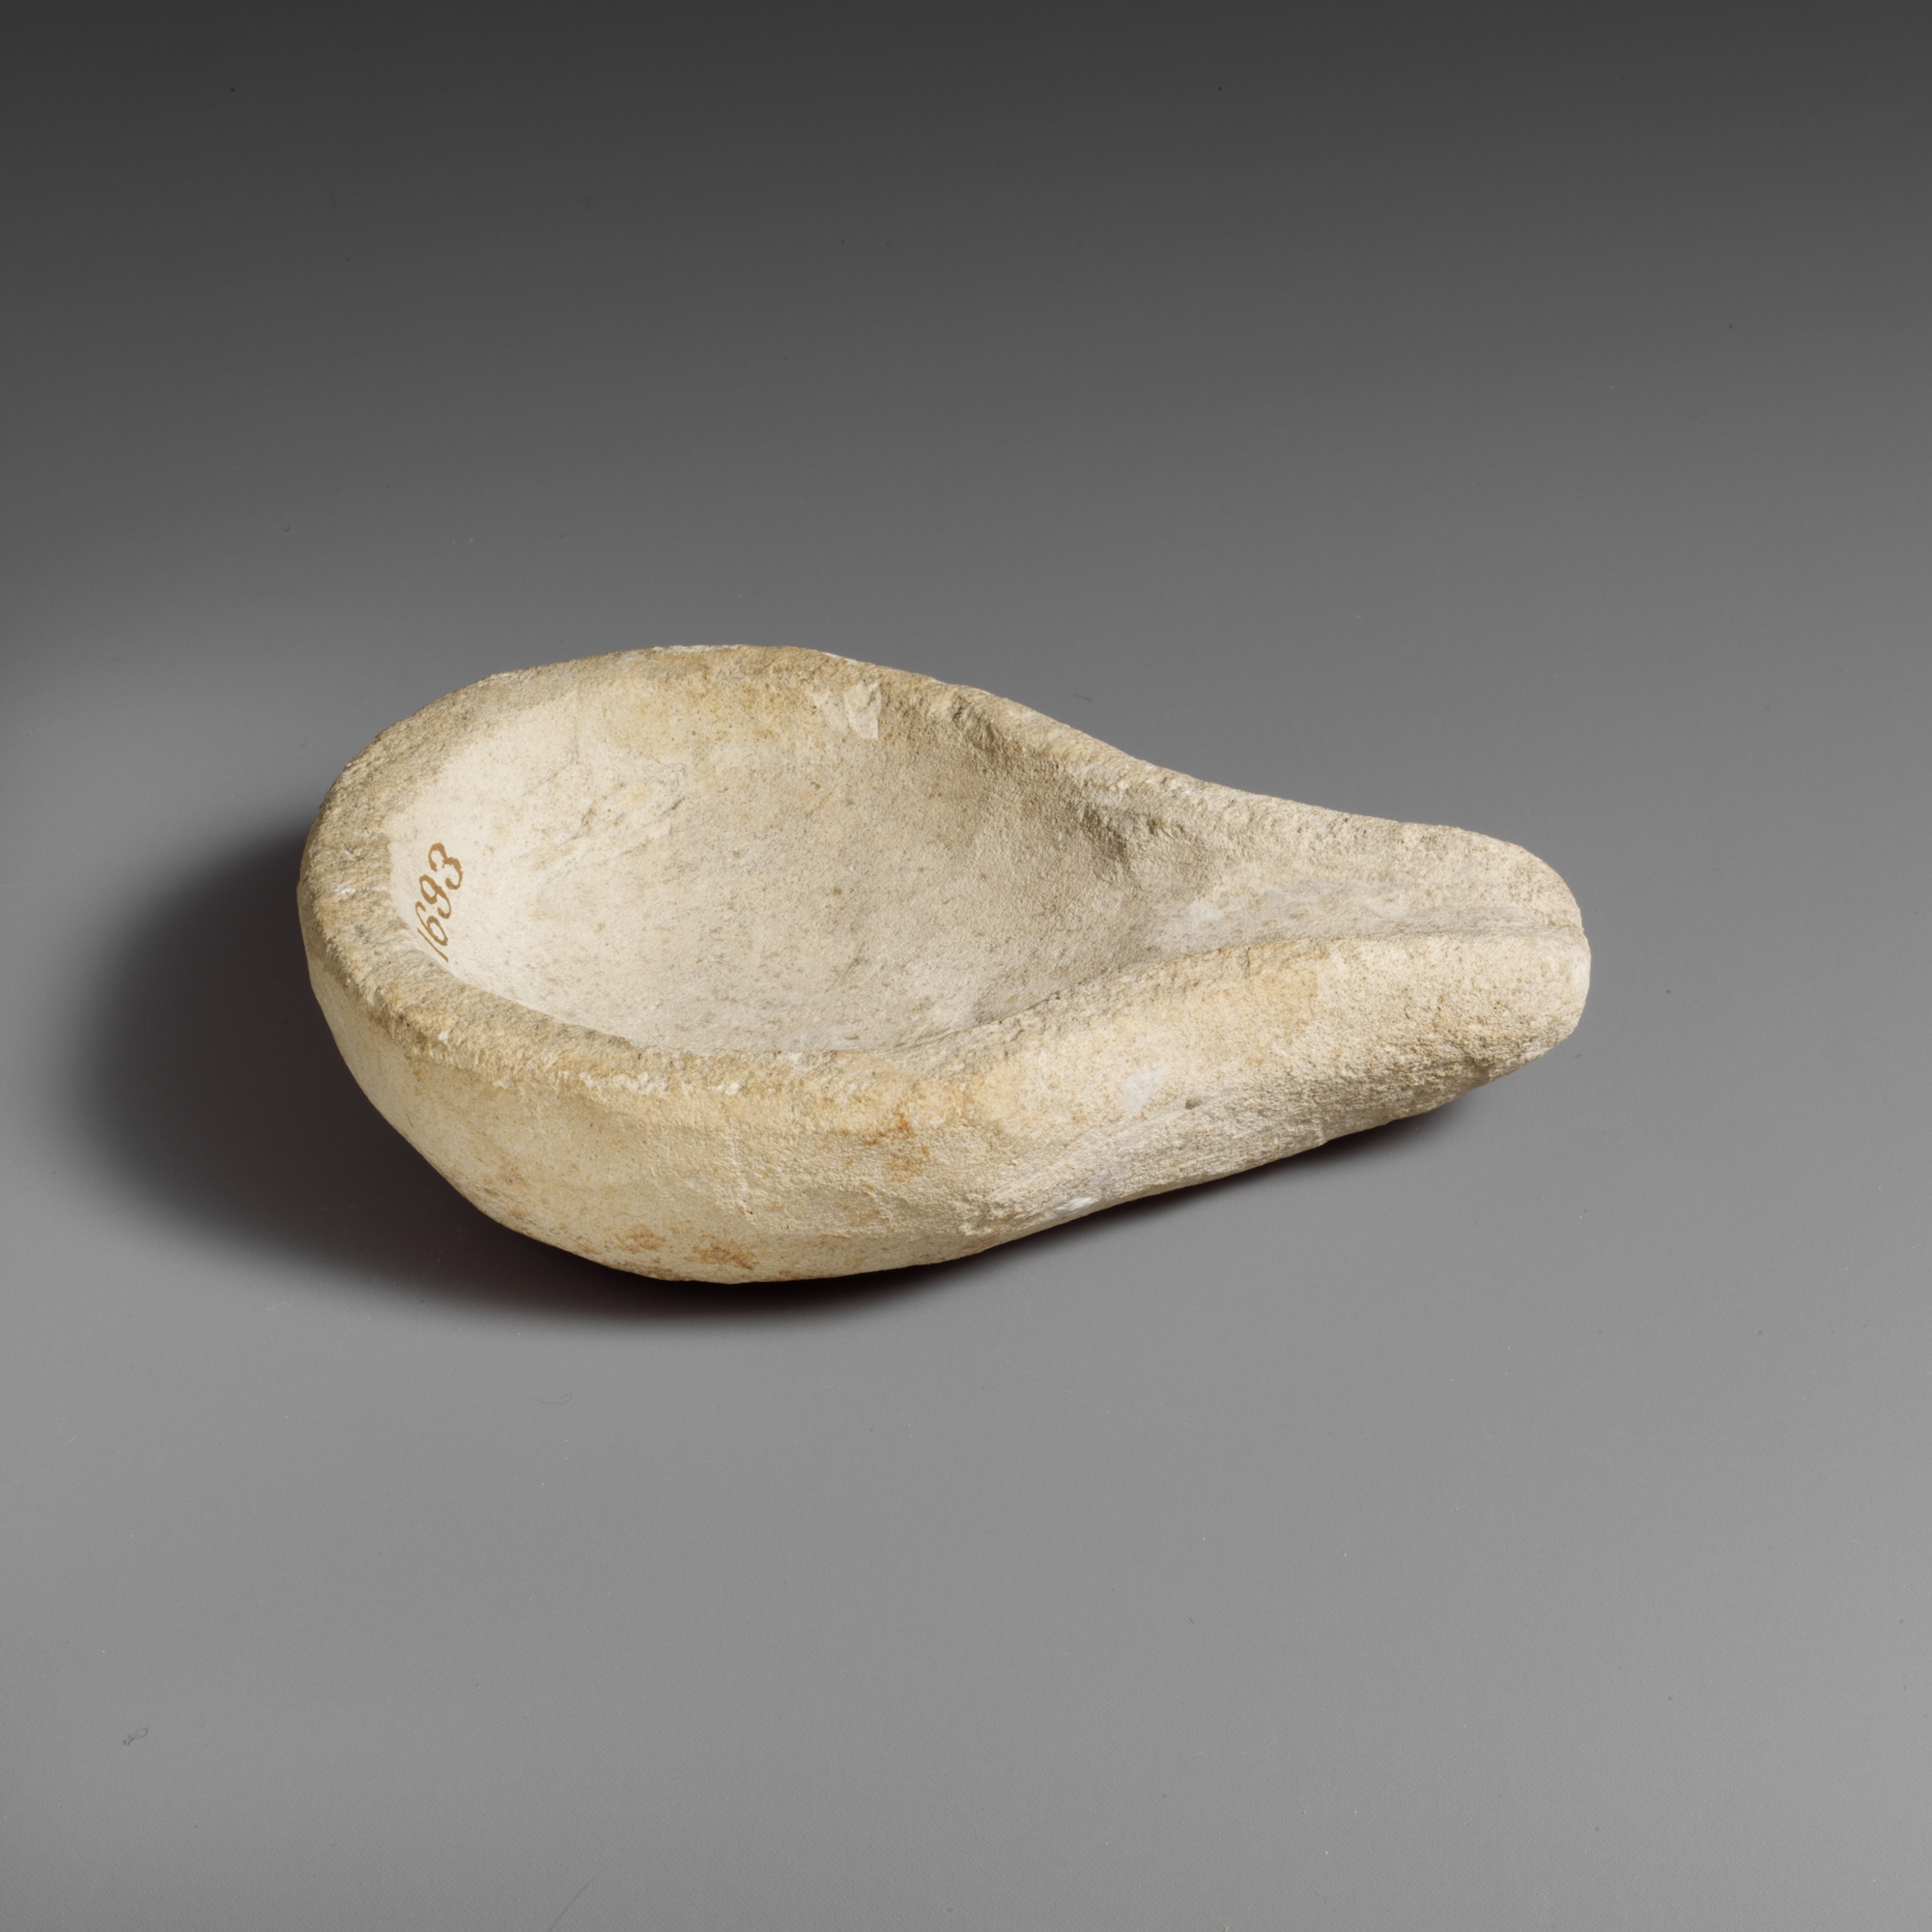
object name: lamp, saucer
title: Limestone saucer lamp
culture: cypriot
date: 500-401 BCE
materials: limestone